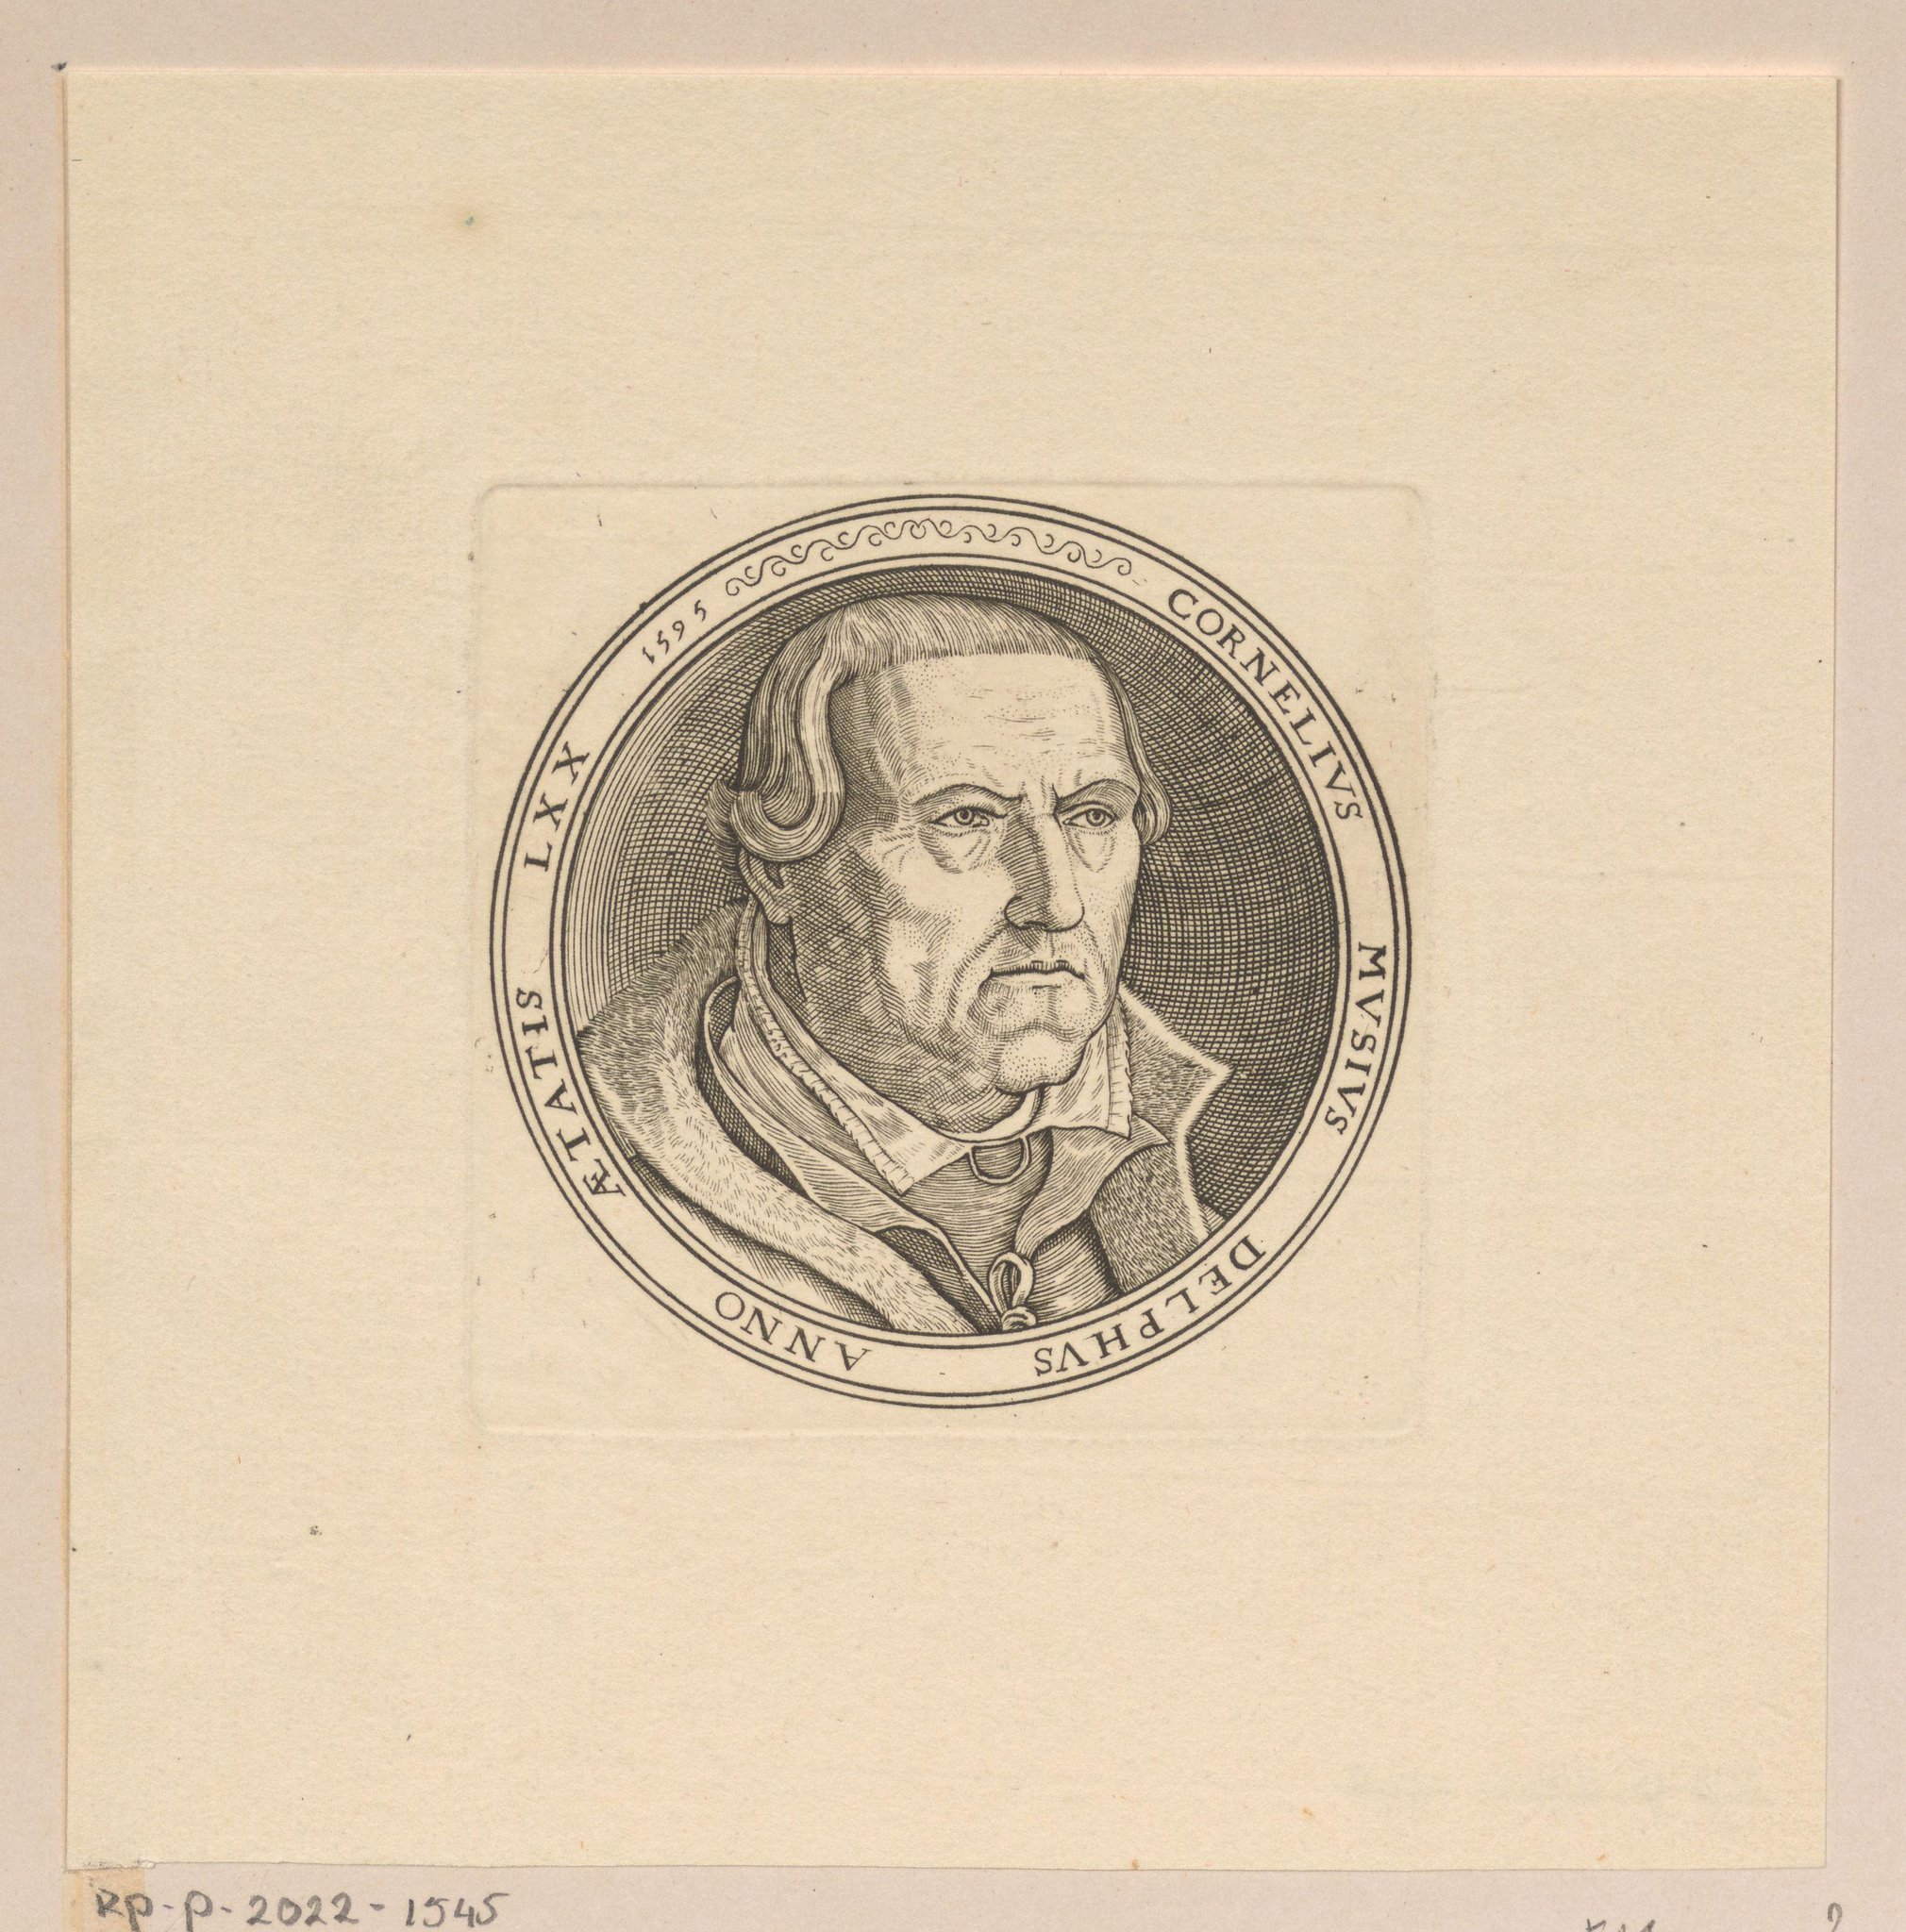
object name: print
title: Portret van Cornelis Musius, op 70-jarige leeftijd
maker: Anonymous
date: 1595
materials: paper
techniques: engraving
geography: delft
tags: delft, leiden, priest, cornelis musius, historical persons, portrait of a writer